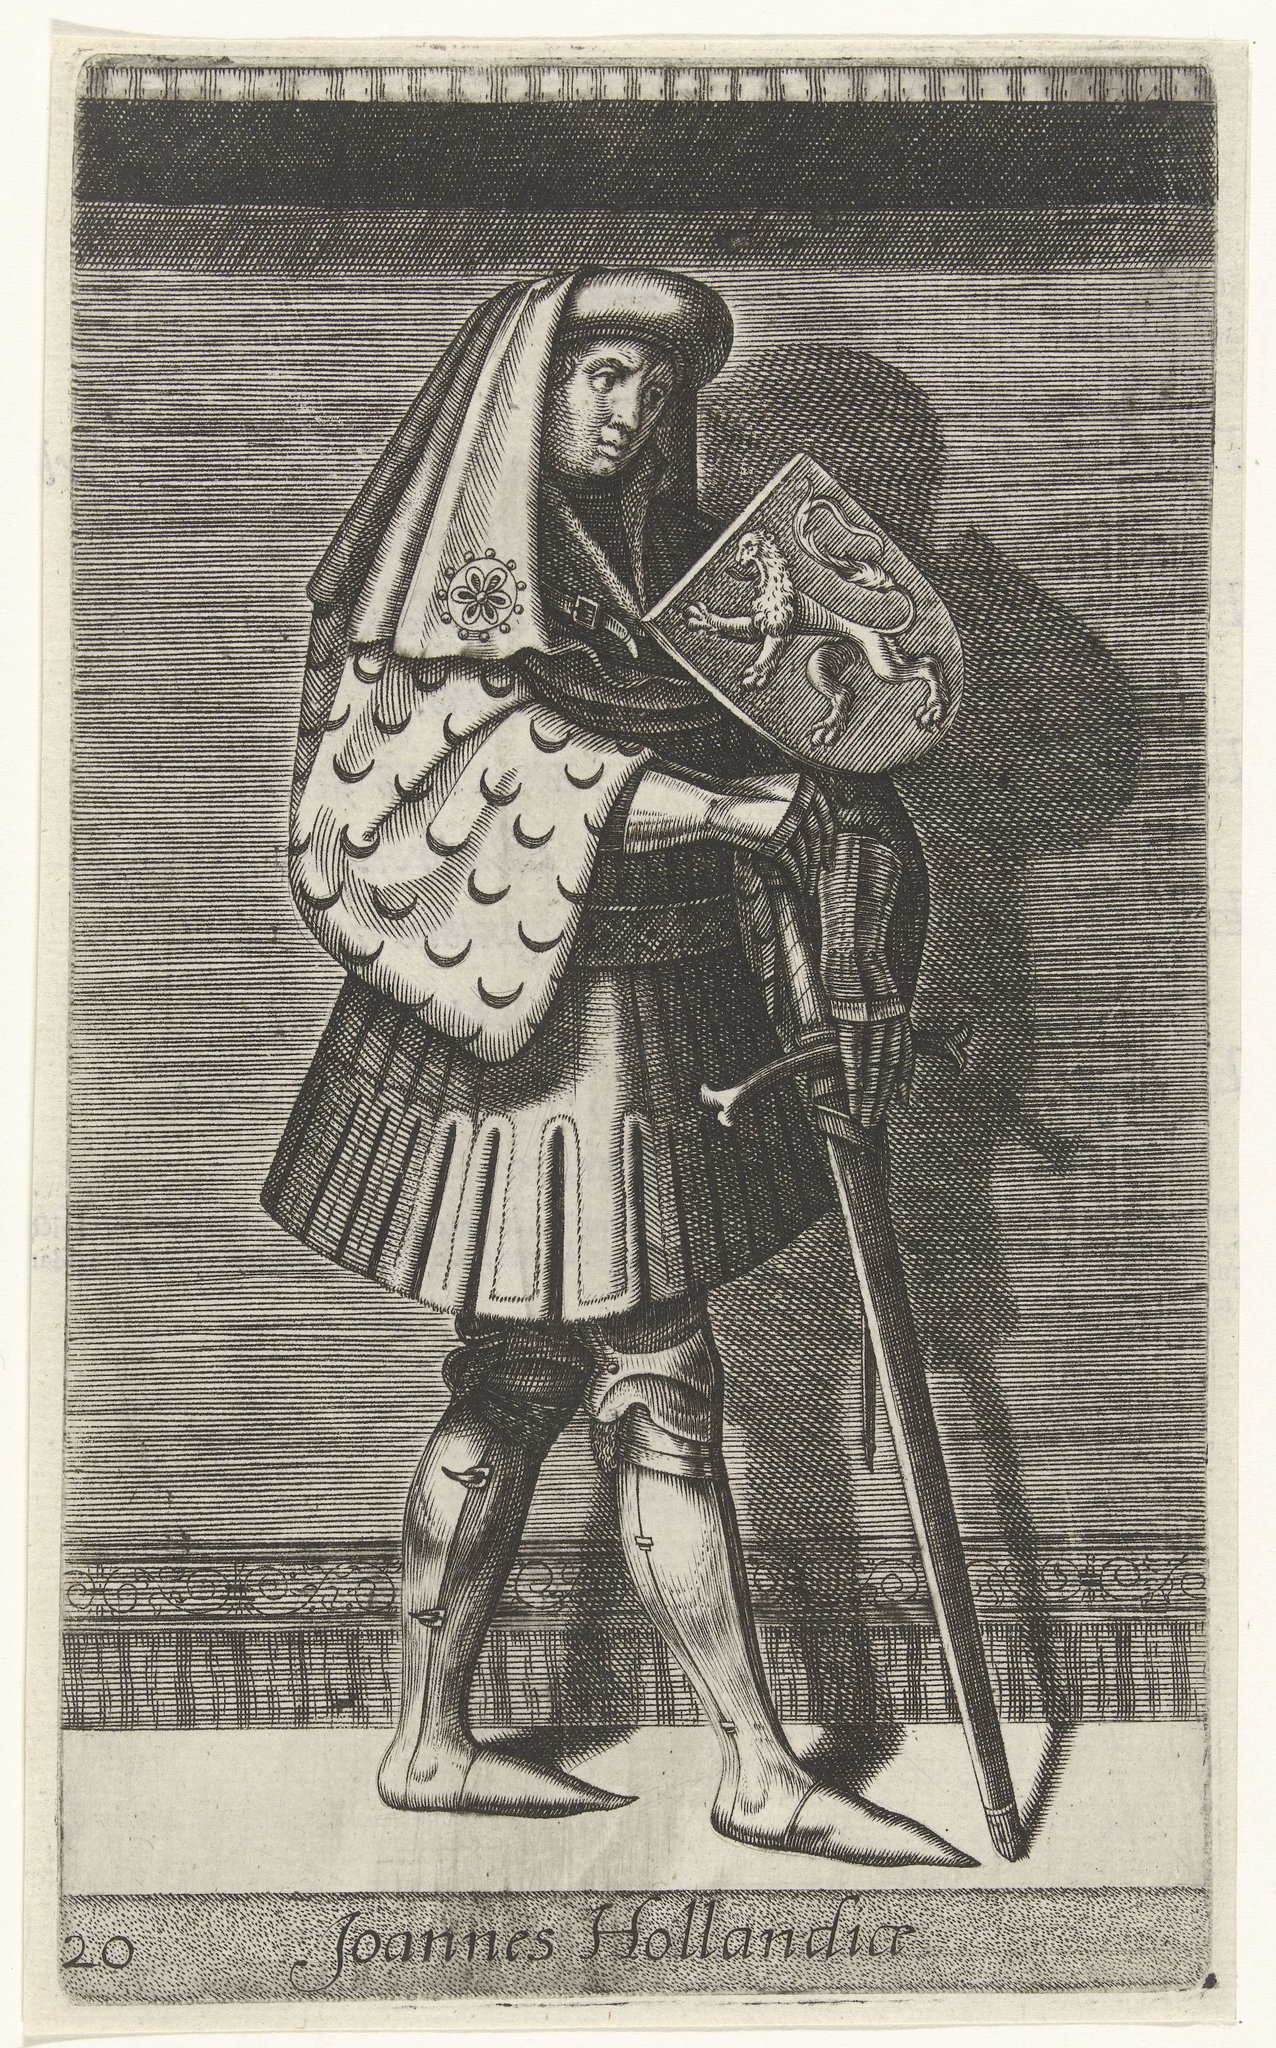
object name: print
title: Principes Hollandiae et Zelandiae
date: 1578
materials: paper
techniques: engraving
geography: antwerp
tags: earl, jan i (graaf van holland)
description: Jan I, graaf van Holland. Staande, ten voeten uit. Hij leunt met beide handen op een zwaard. Op zijn linkerschouder het wapenschild van Holland. De prent dient als een illustratie bij een boek over de geschiedenis van de graven van Holland.